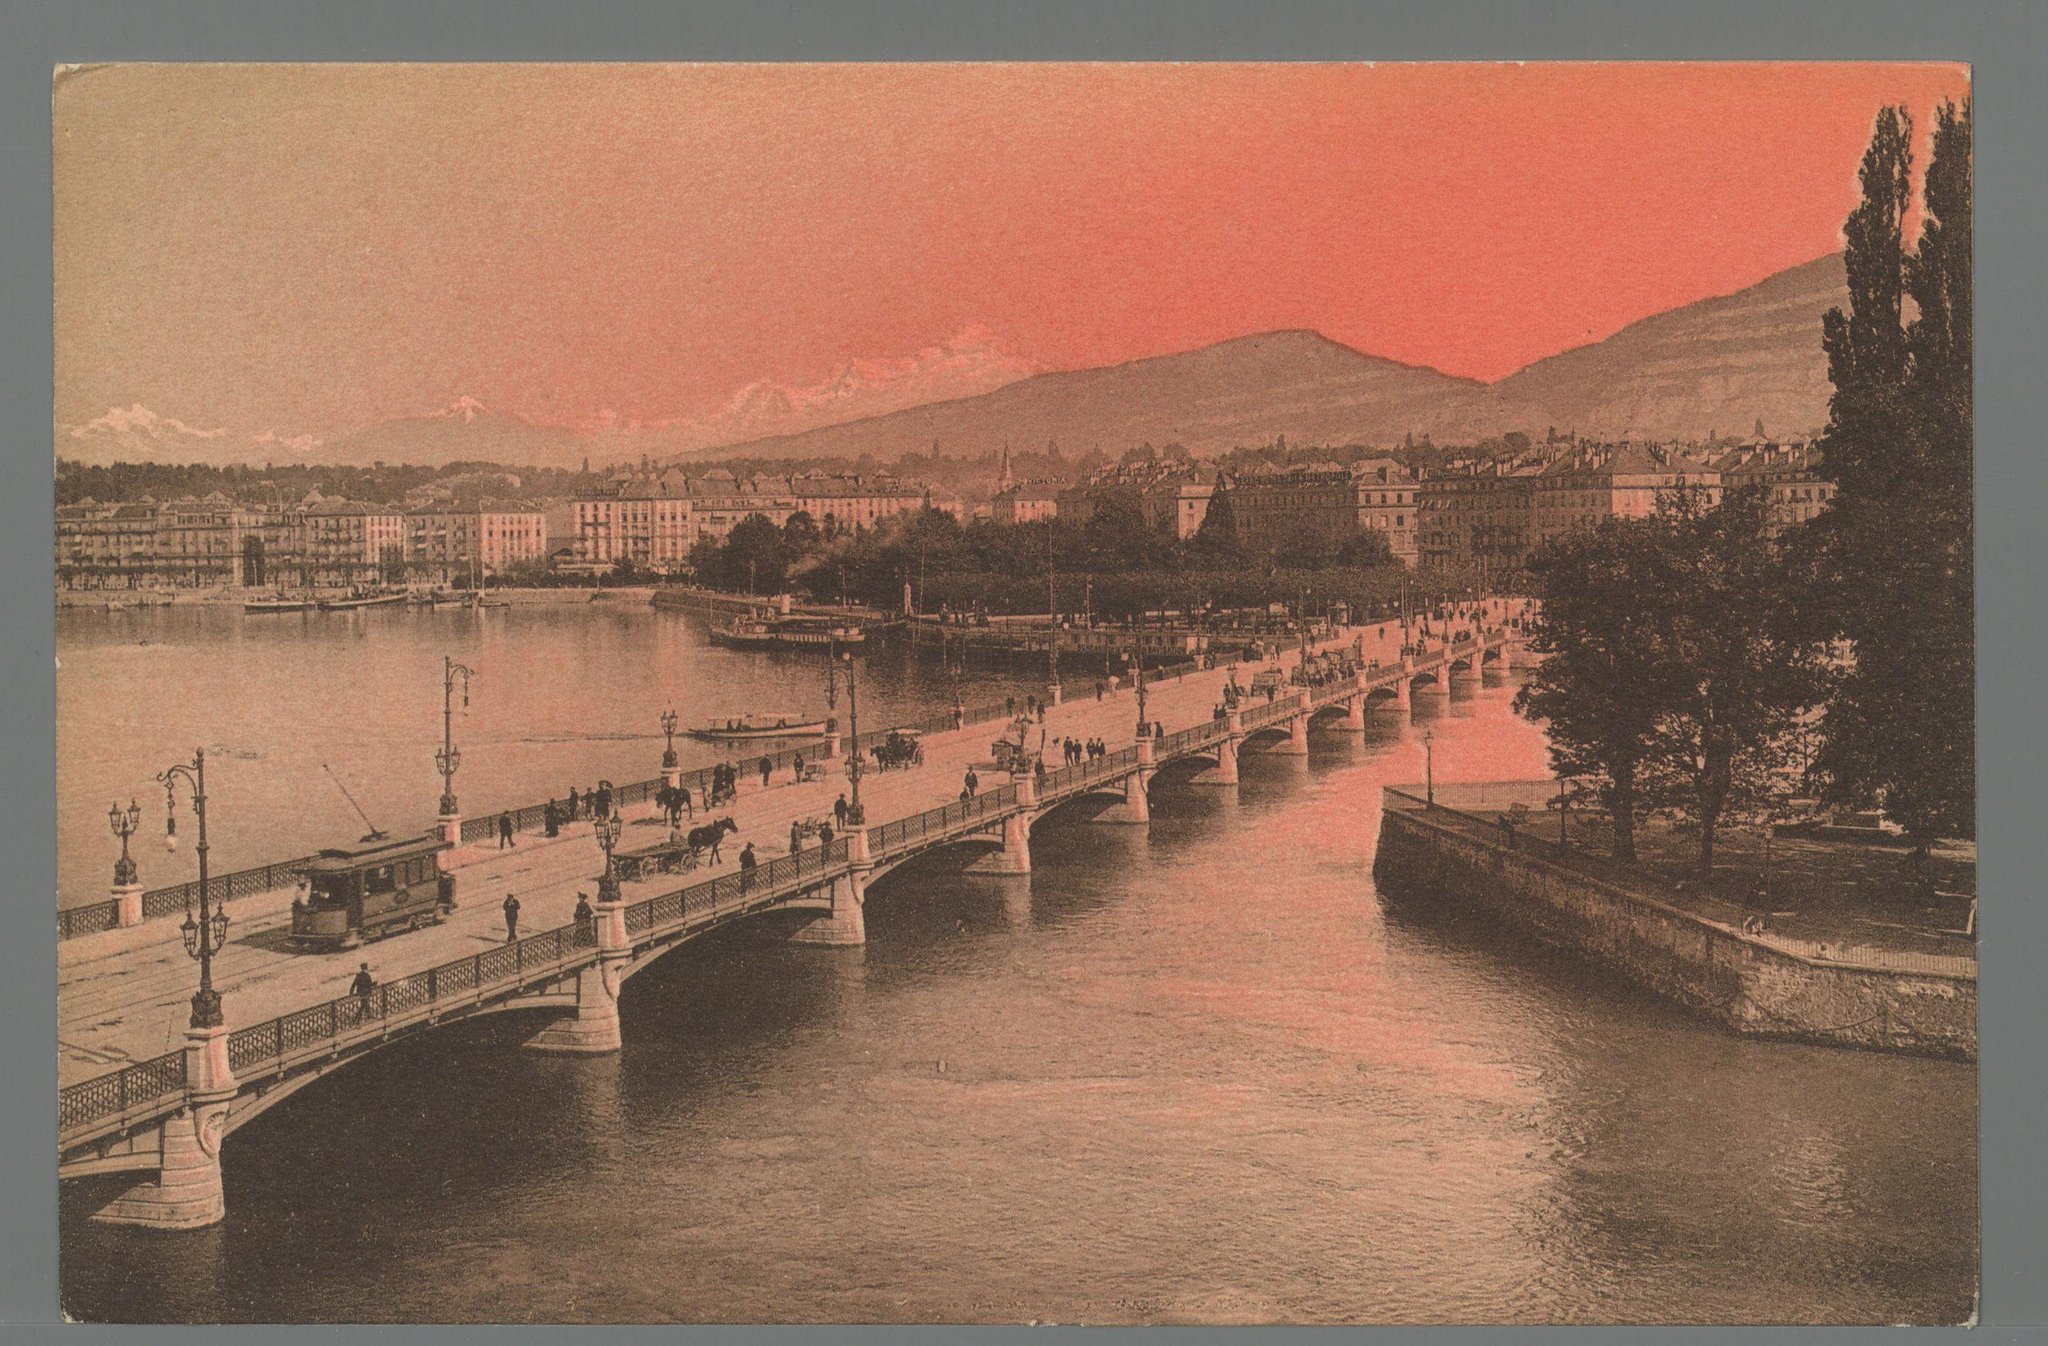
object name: photomechanical print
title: Genève et le Mont-Blanc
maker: Anonymous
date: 1905-1909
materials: cardboard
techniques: photograph, lithograph, writing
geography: geneva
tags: bridge in city across river, canal, etc. (+ city(-scape) with figures, staffage), mountains